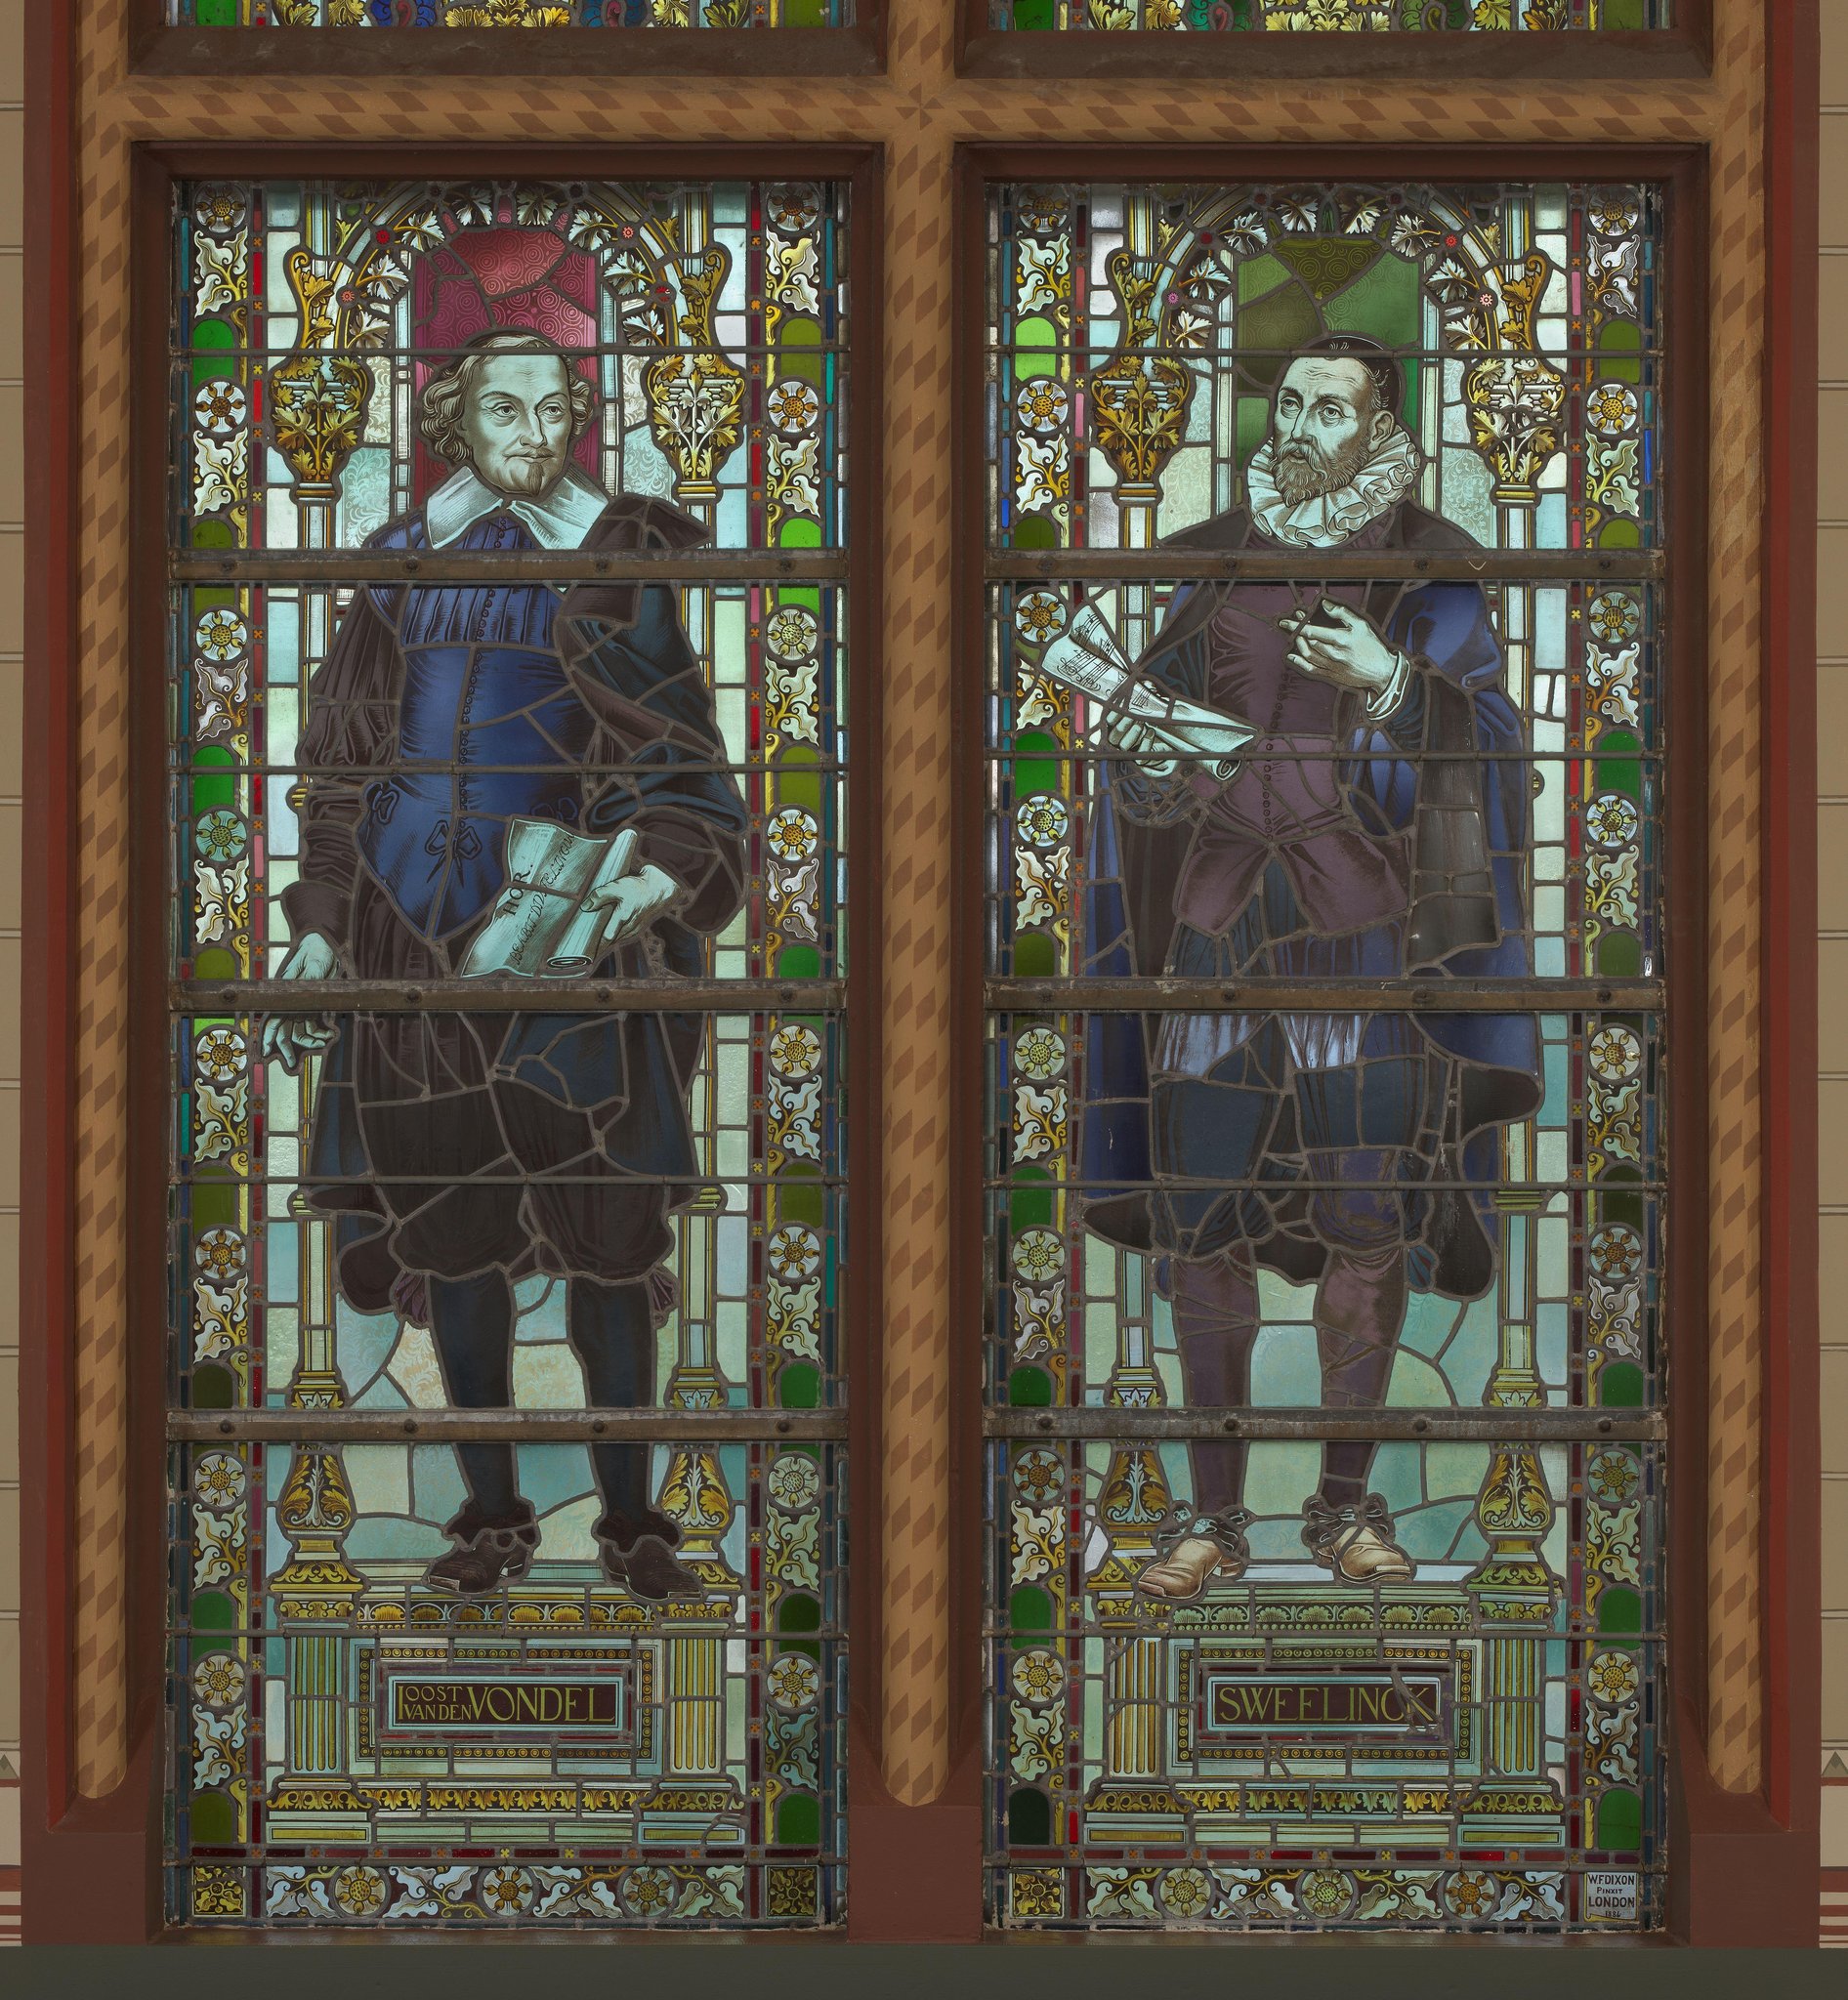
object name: light window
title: Raam met voorstelling van de musicus Jan Pietersz Sweelinck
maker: william francis dixon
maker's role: glasschilder, glazenier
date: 1883-1884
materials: glass, lead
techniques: leading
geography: england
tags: deventer, amsterdam